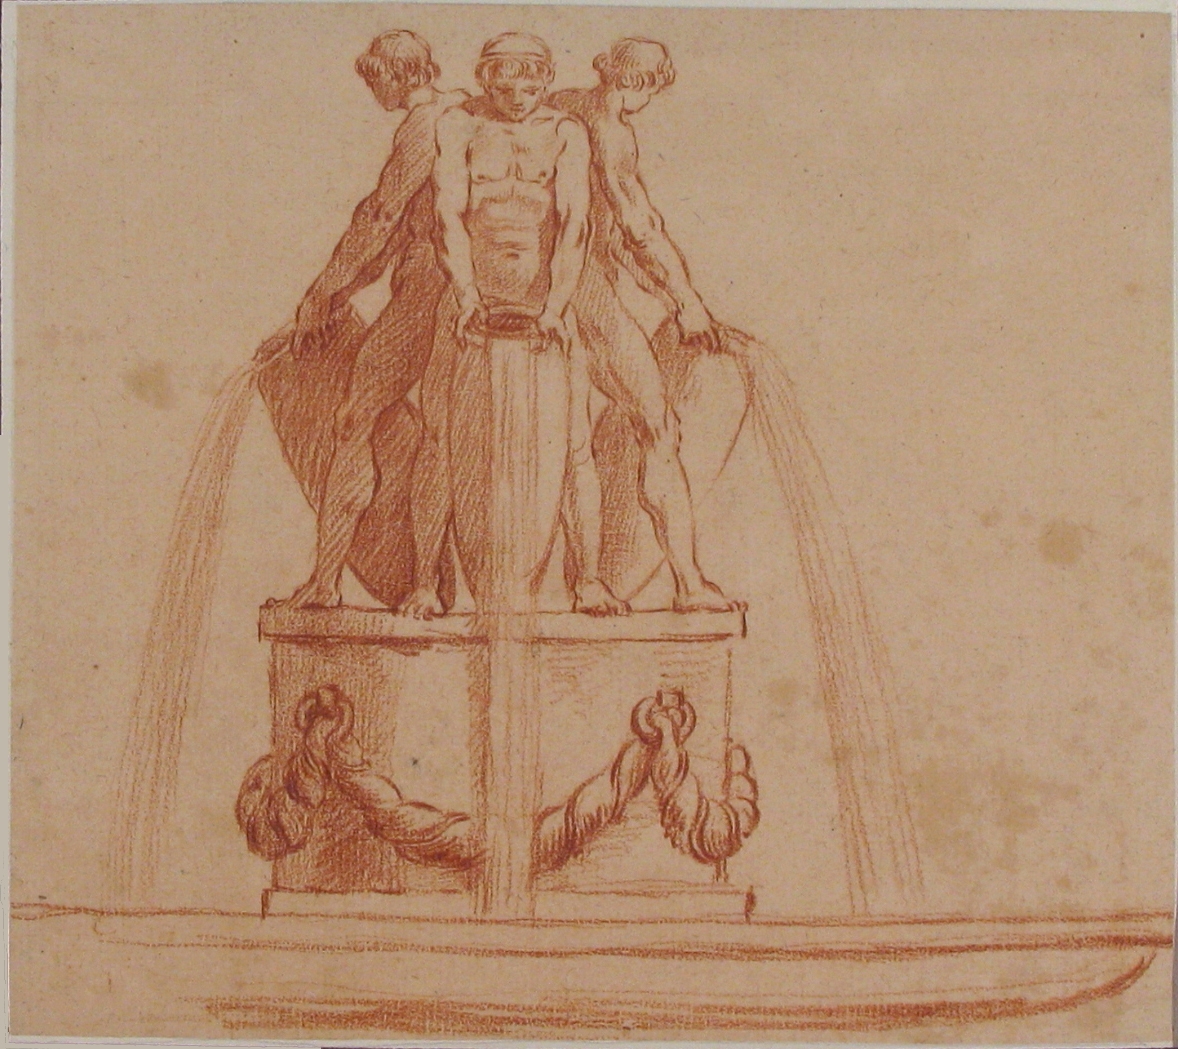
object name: drawing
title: Design for a Fountain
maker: anonymous, french, 18th century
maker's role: artist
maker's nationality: french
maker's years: 1700-1800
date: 1701-1800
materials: chalk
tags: fountains,male nudes